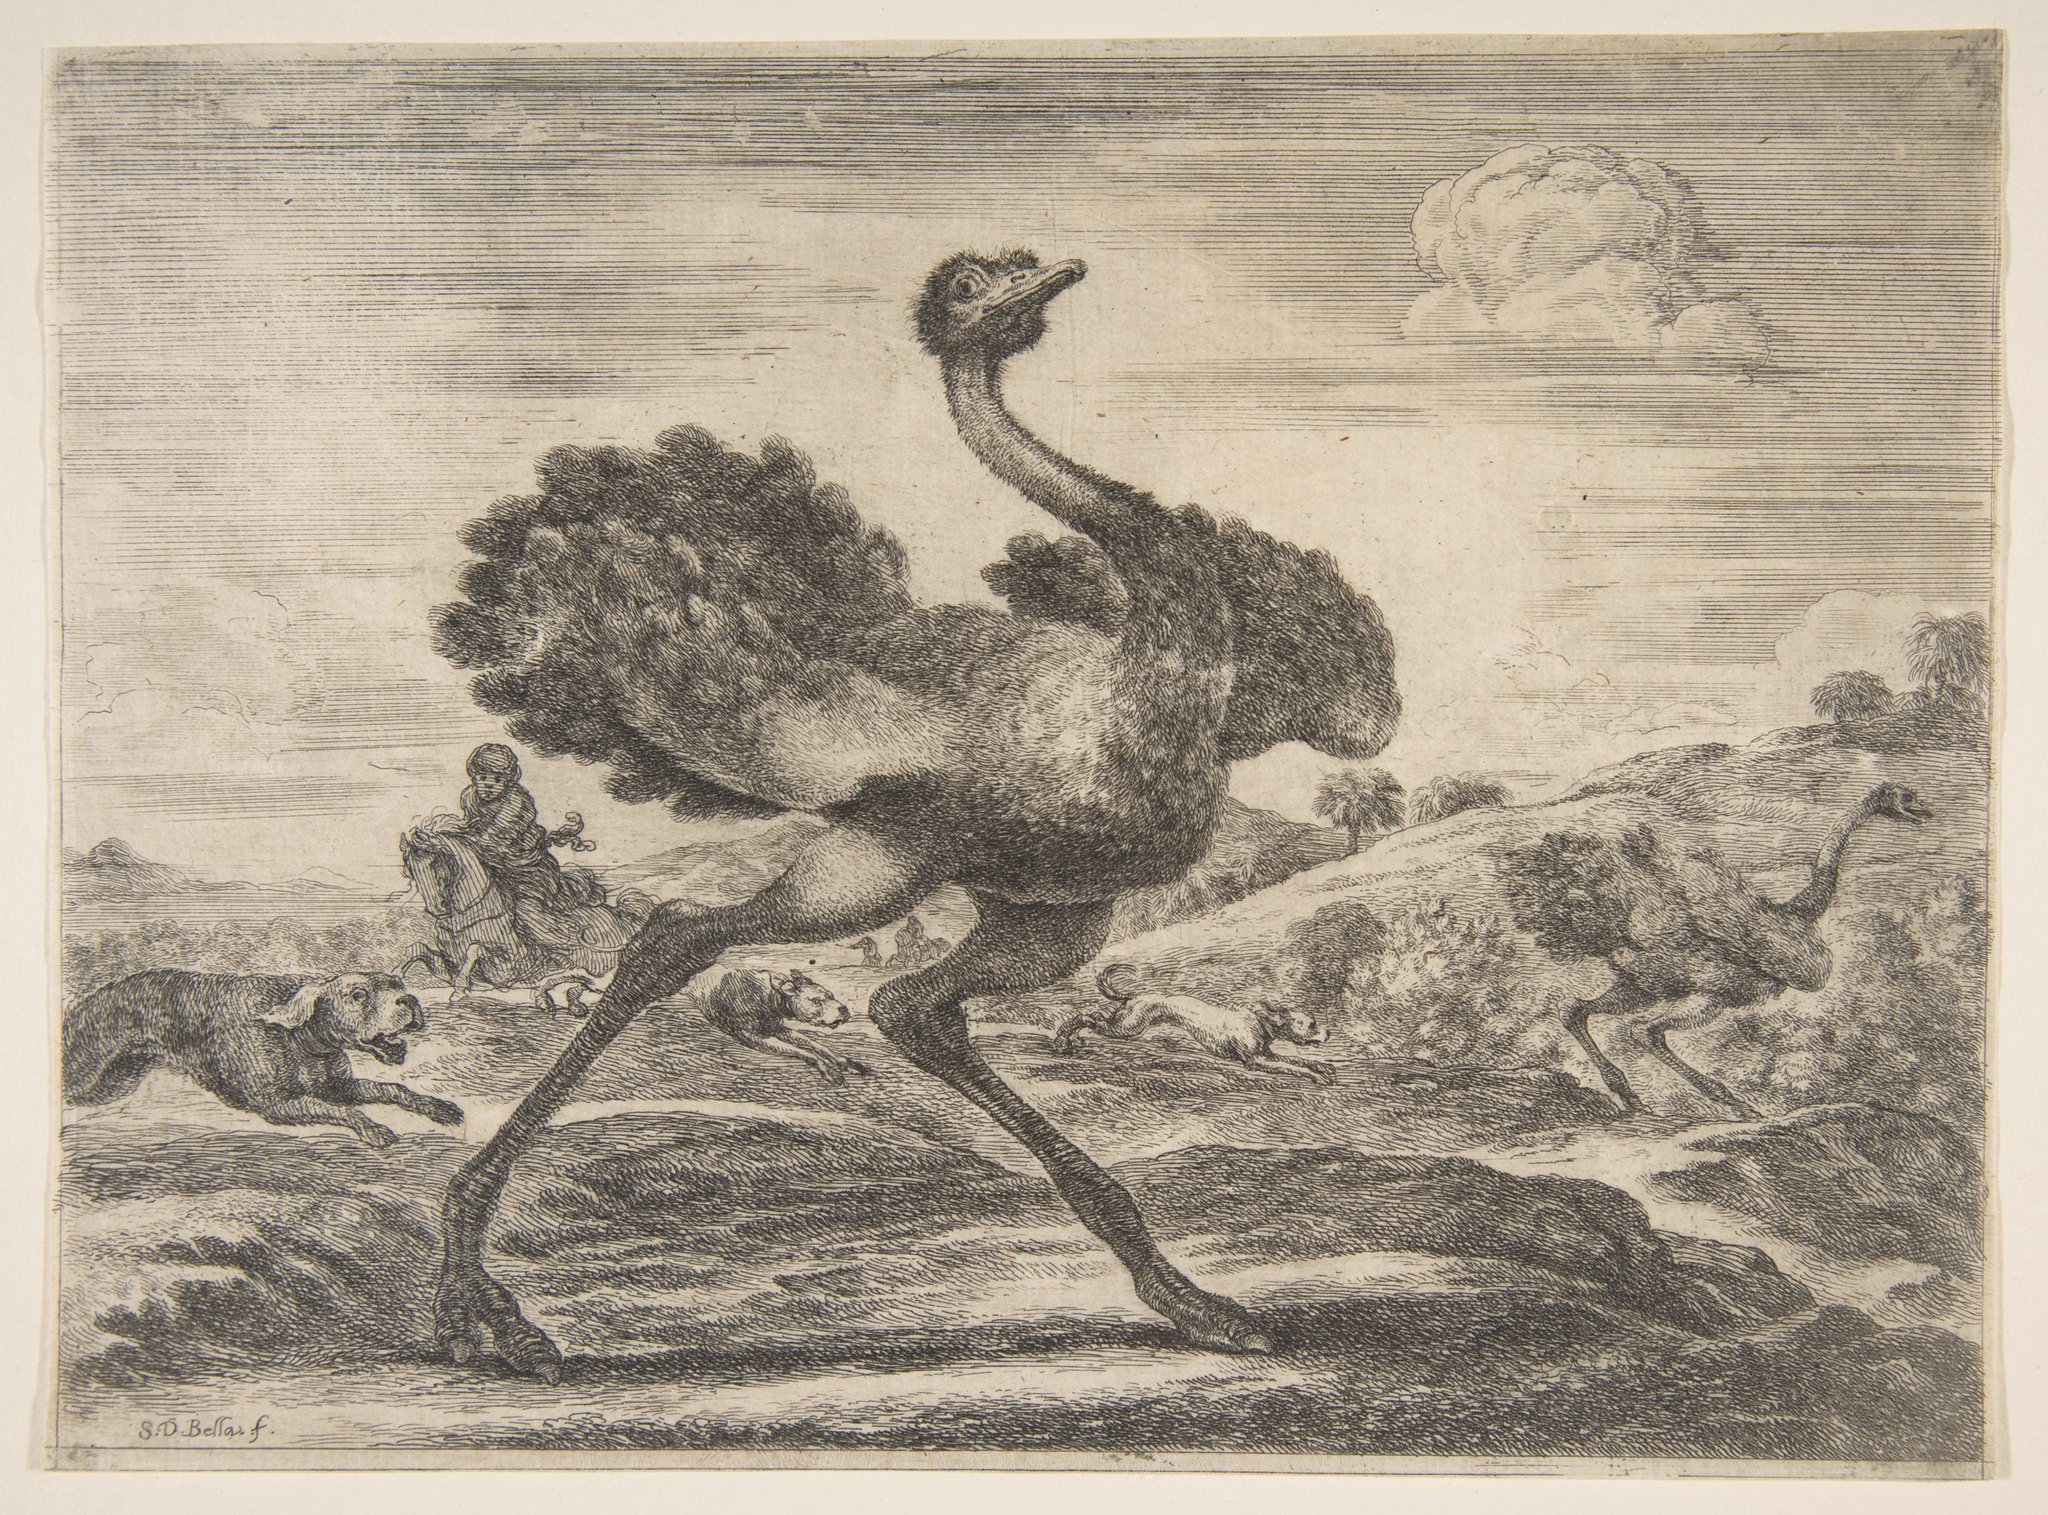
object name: print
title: Ostrich hunt, from 'Animal hunts' (Chasses à différents animaux)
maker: stefano della bella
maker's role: artist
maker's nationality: italian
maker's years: 1610-1664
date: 1654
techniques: etching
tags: birds,men,hunting,dogs,horses